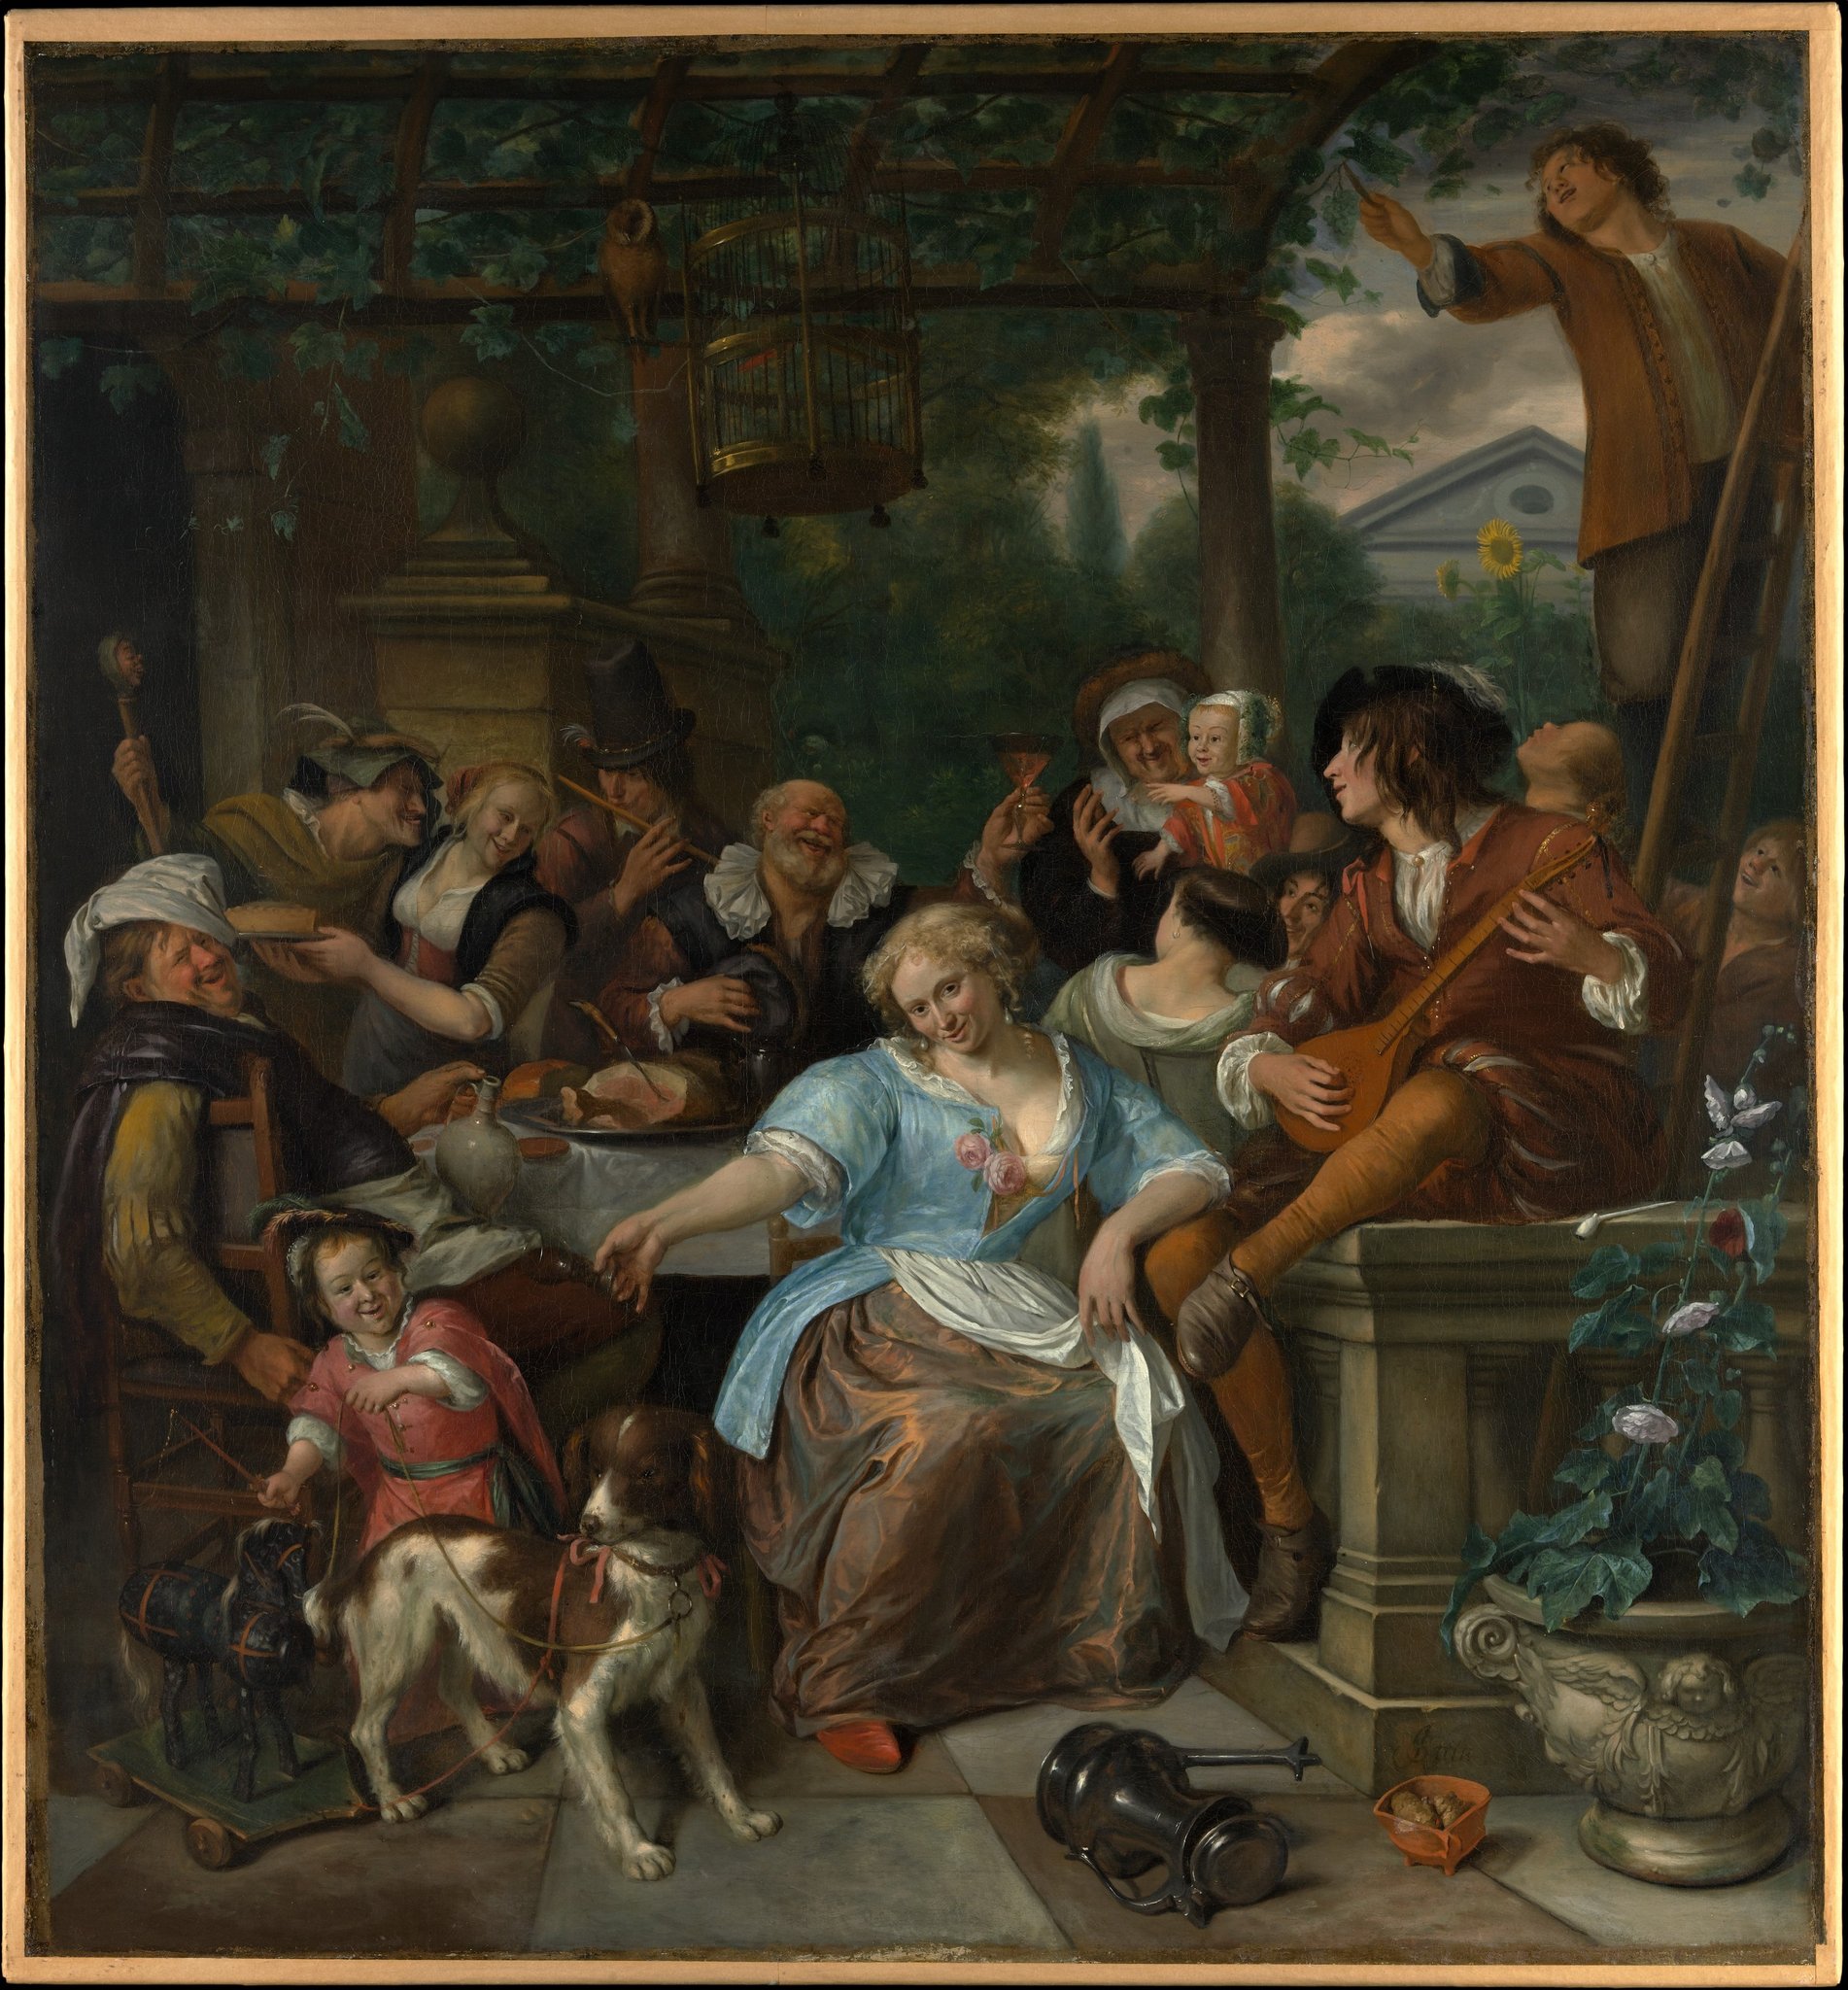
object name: painting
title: Merry Company on a Terrace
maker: jan steen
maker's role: artist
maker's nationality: dutch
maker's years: 1626-1679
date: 1670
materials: canvas, oil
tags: food,children,men,women,dogs,dining,musicians,toys